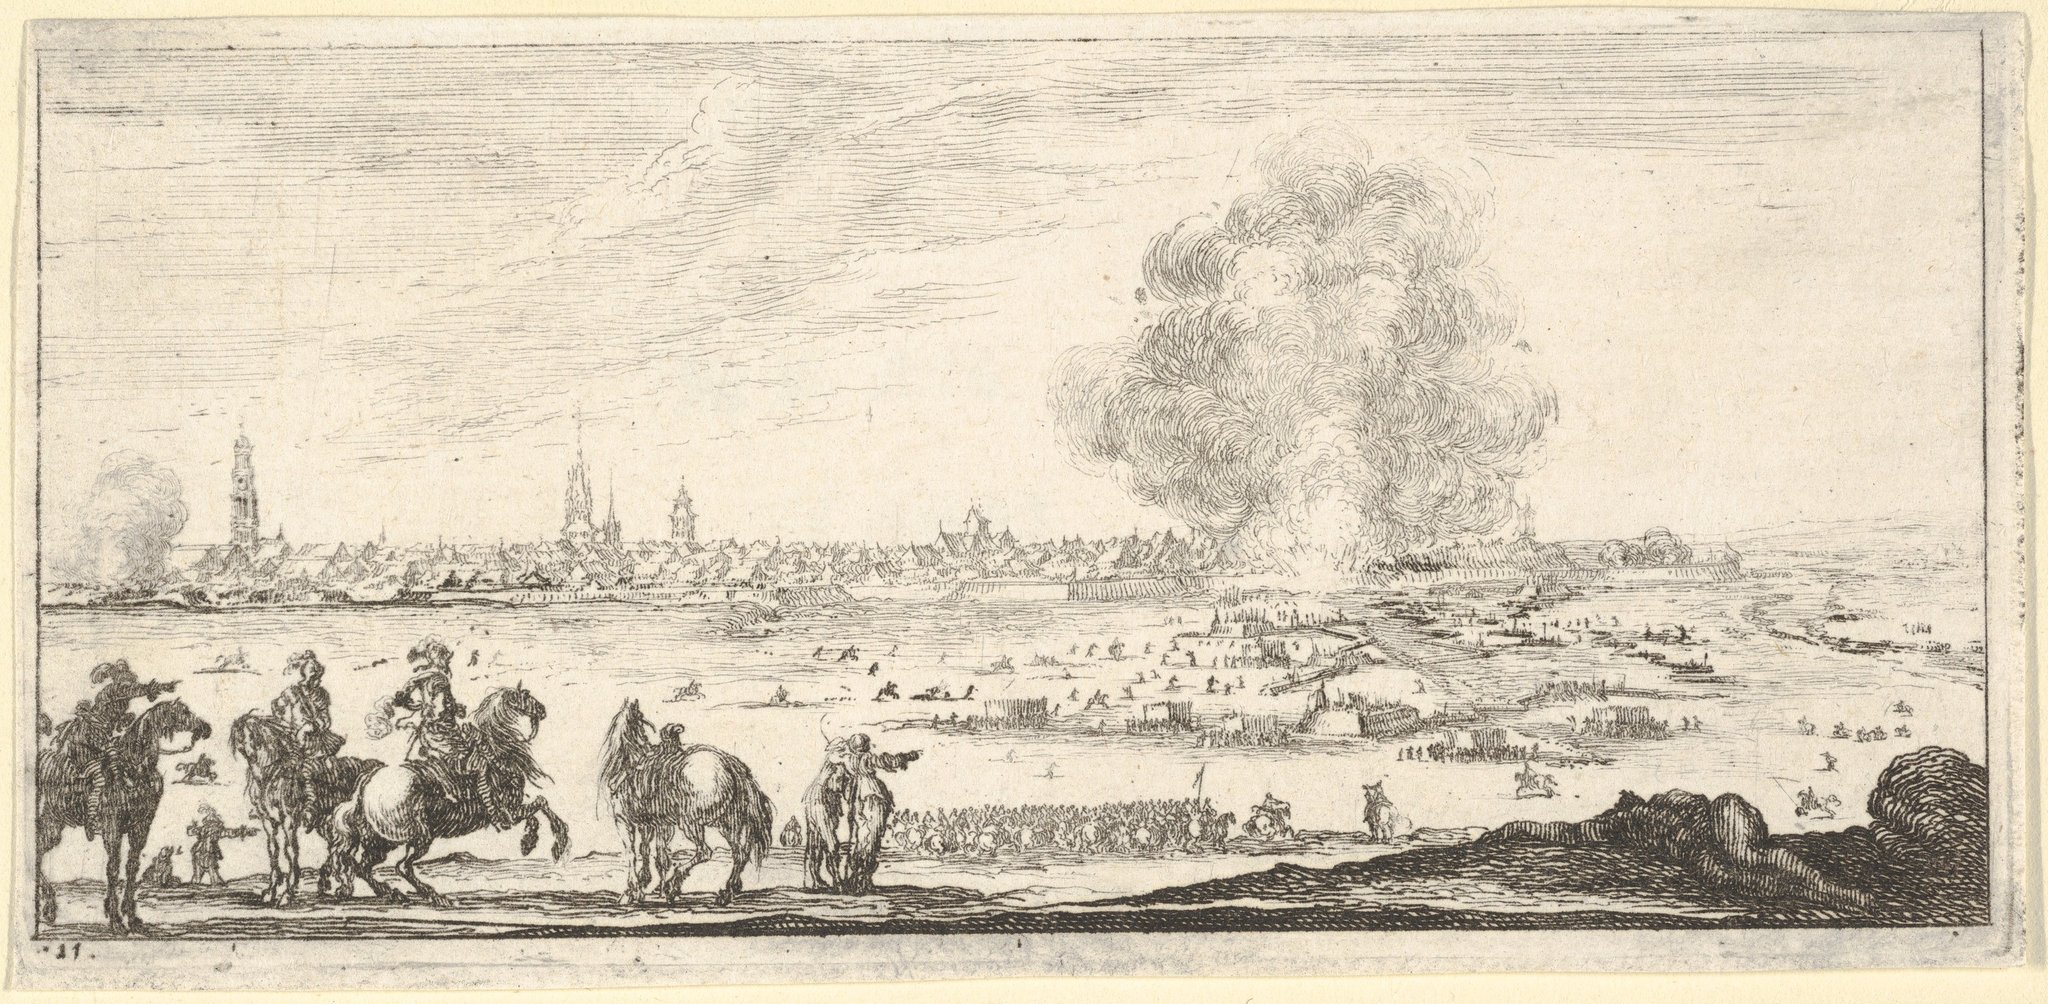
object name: print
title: Plate 11: an attack on a city, horsemen in foreground, clouds of smoke and a cityscape in background, from "Troops, cannons, and attacks on towns" (Dessins de quelques conduites de troupes, canons, et ataques de villes)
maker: stefano della bella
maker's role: artist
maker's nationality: italian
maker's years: 1610-1664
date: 1640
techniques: etching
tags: cities,men,horses